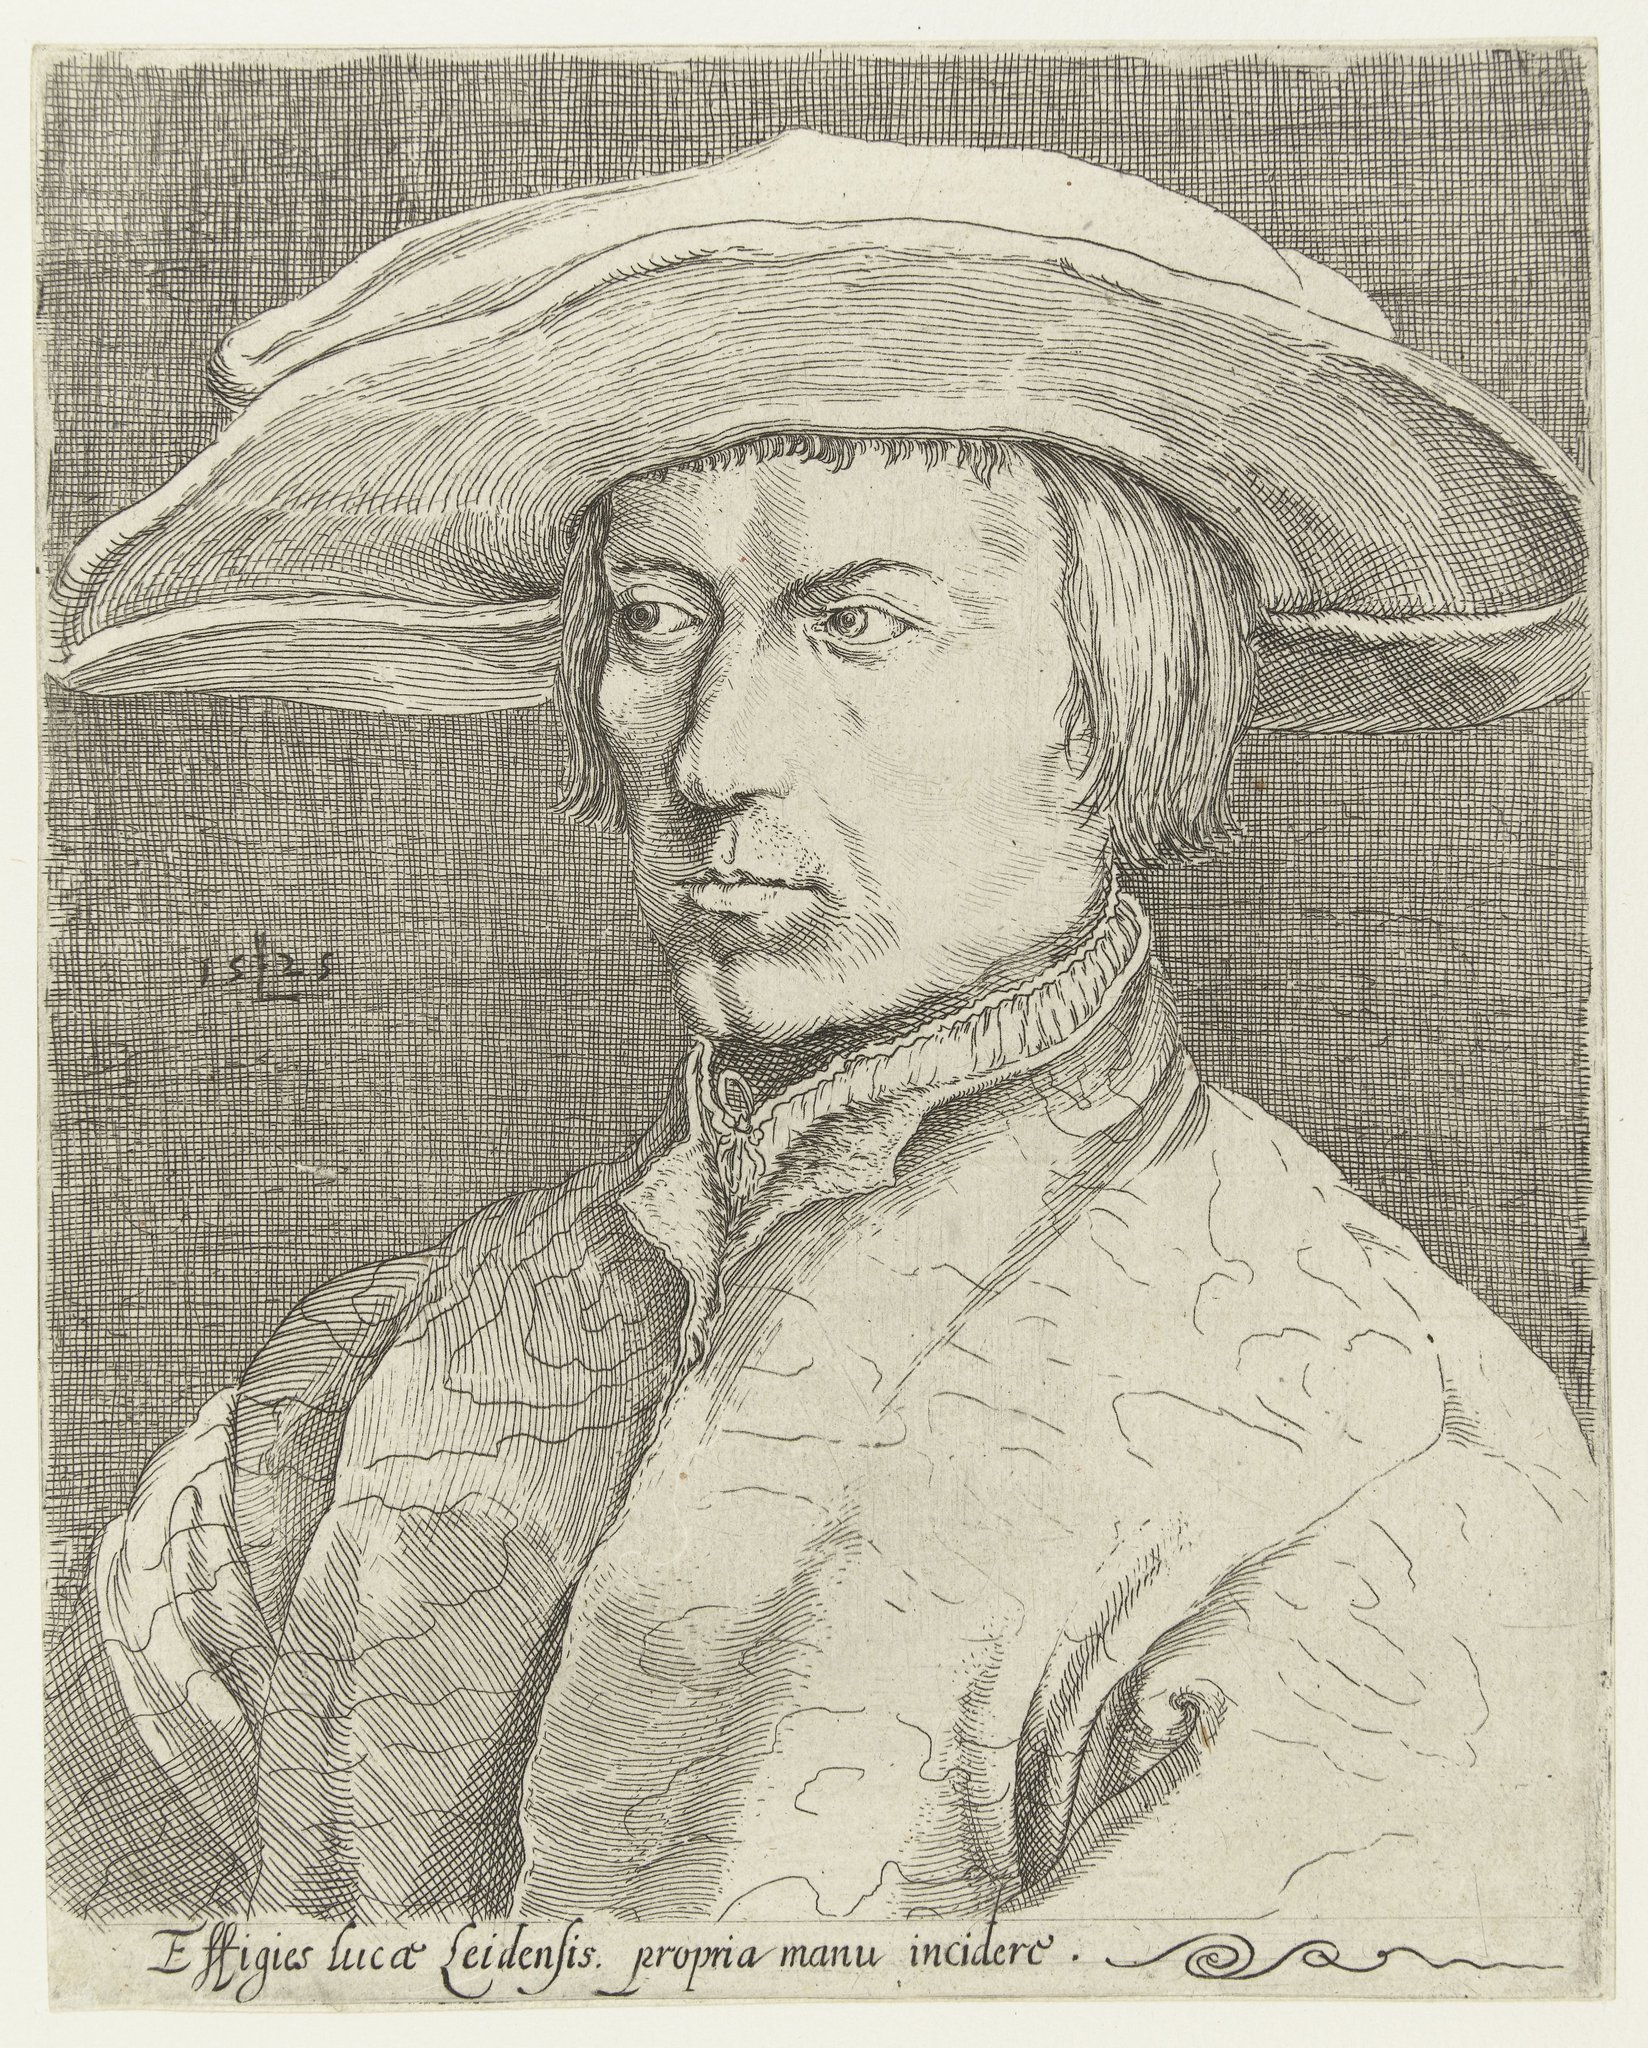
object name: print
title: Het zogenaamde zelfportret van Lucas van Leyden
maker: Anonymous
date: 1575-1625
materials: paper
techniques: etching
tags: painter, print maker, draughtsman, lucas van leyden, portrait, self-portrait of artist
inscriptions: collector's mark: Lugt 2228a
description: Imitatie van Lucas van Leyden, een zogenaamd zelfportret van de kunstenaar, met initiaal en jaartal 1525. Onder het portret de tekst: Effigies Lucas Leidenis propria manu incidere.